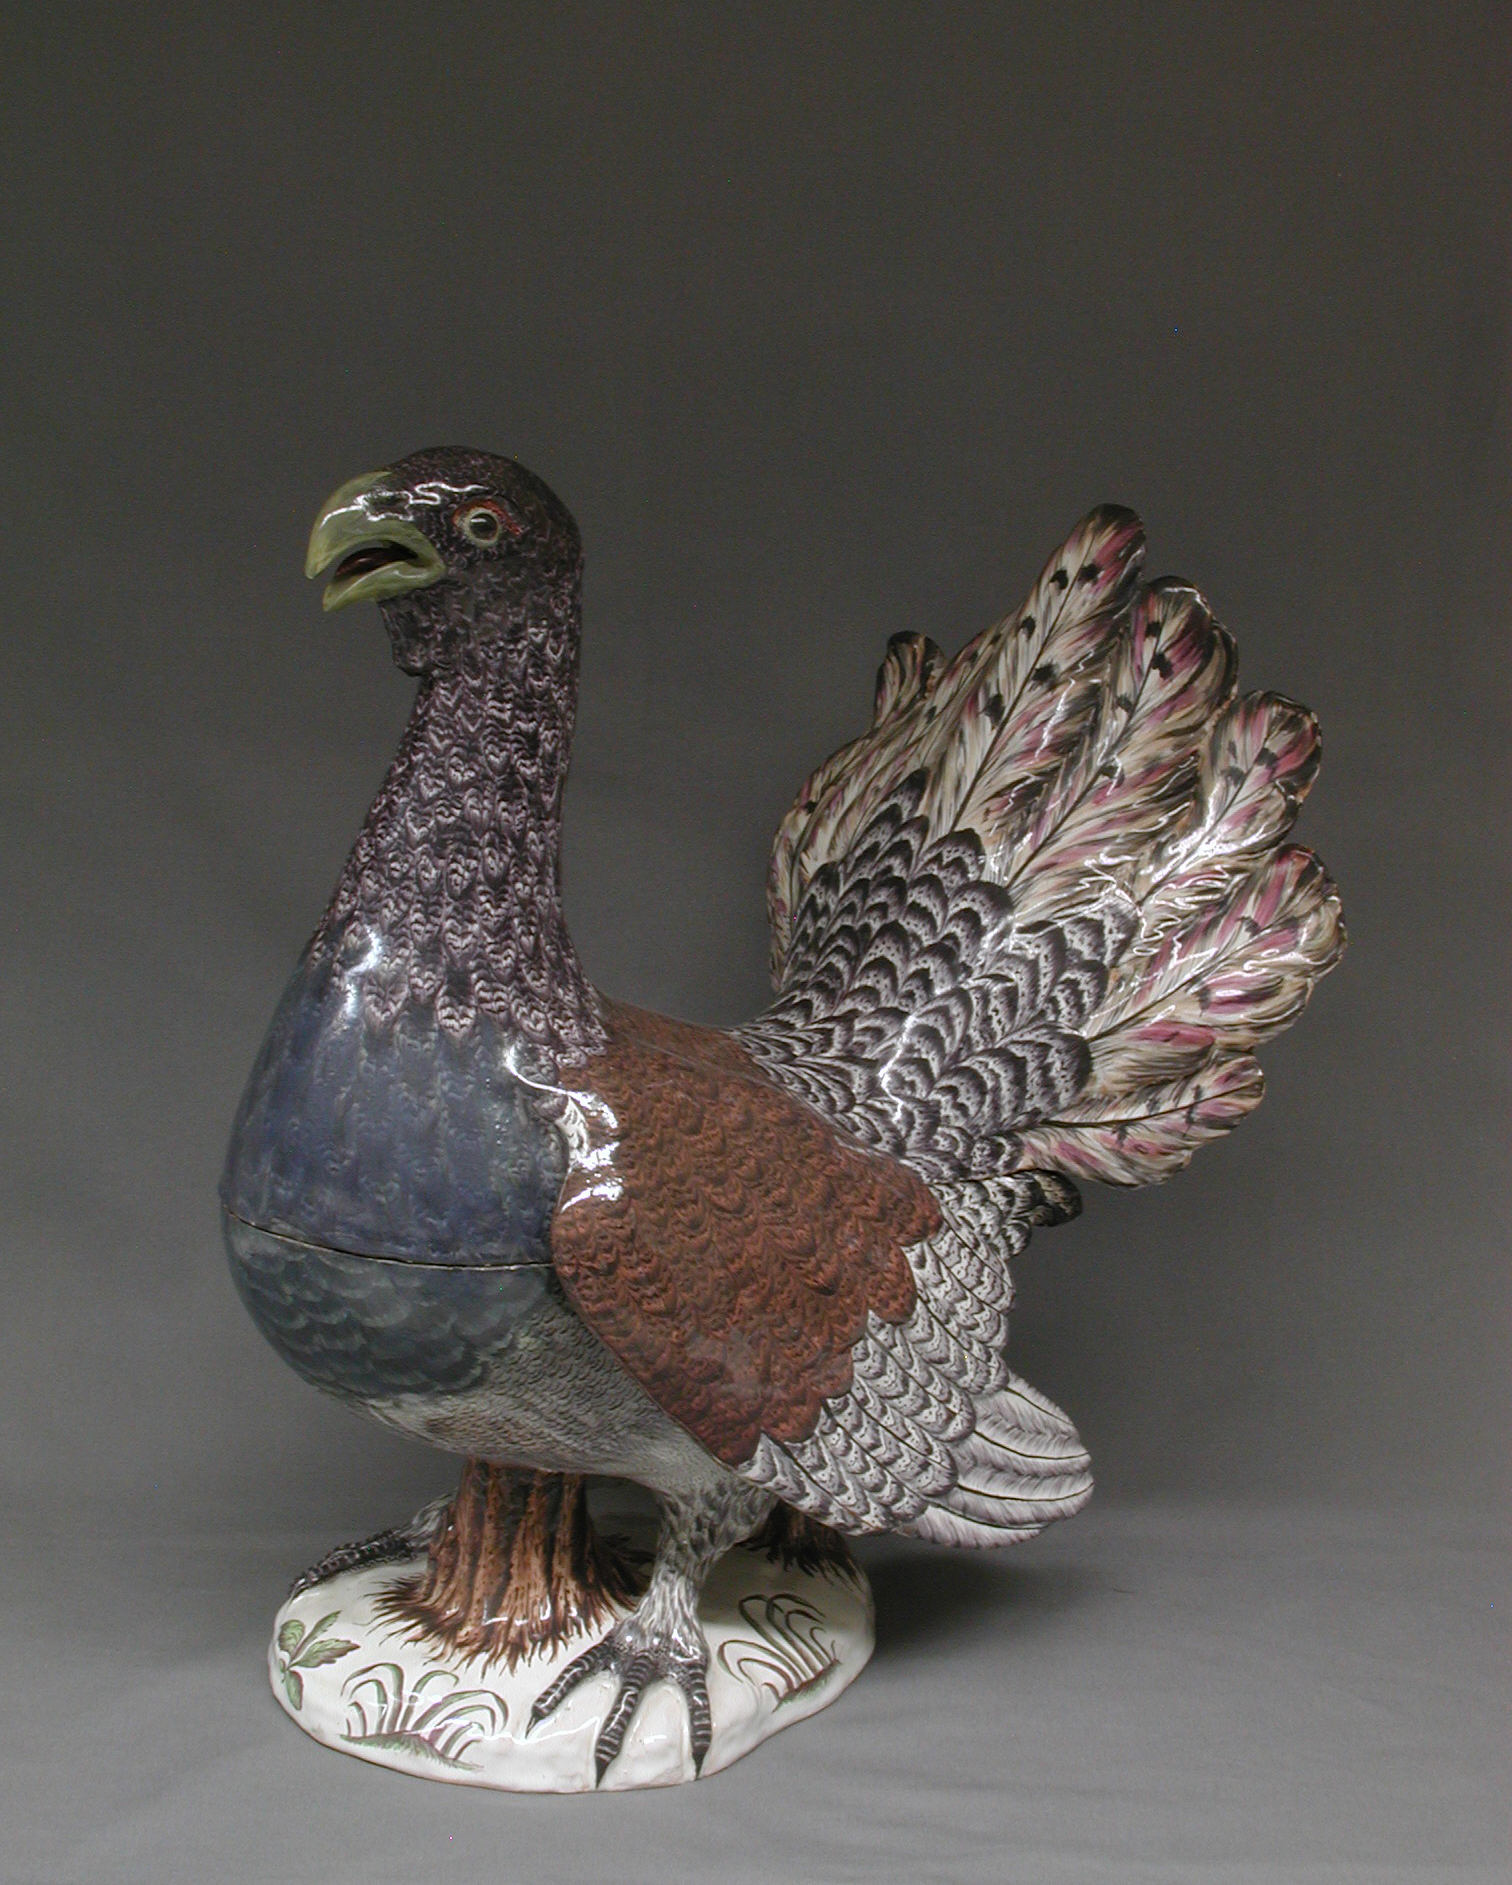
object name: tureen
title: Tureen in the form of a capercaillie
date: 1750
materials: faience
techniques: glazing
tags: birds